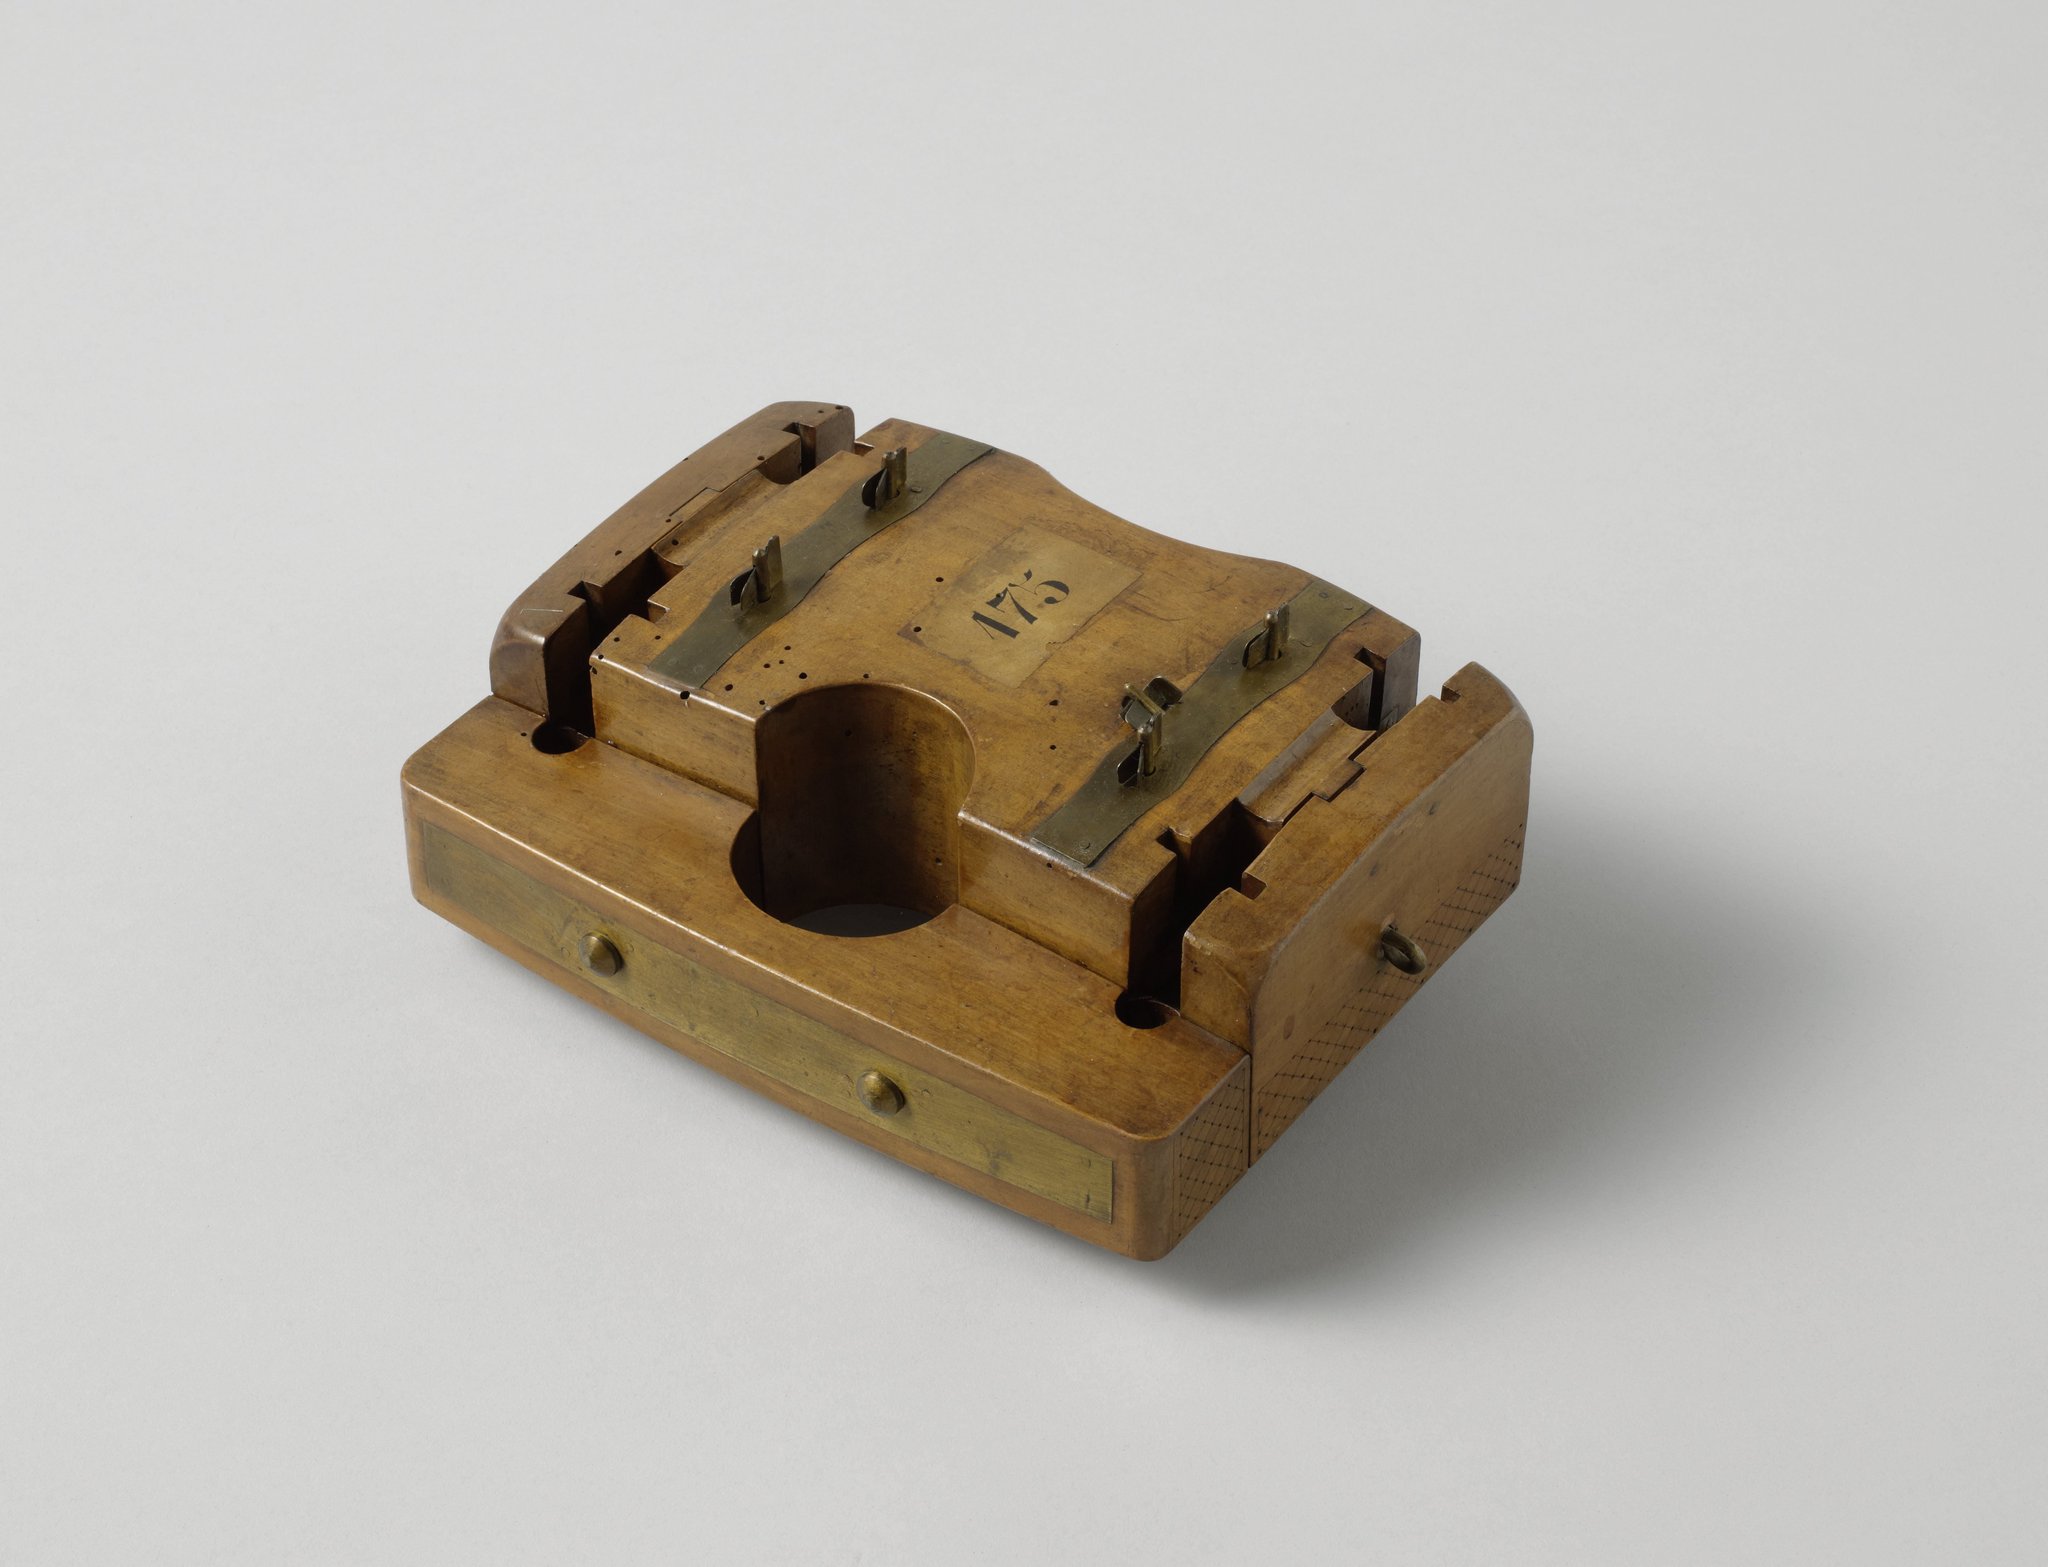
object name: demonstration model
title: Model of a Mast Cap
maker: Anonymous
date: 1780-1840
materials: brass, wood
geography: netherlands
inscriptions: label, on the top: ‘175’ former inventory label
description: Model van een ezelshoofd bestaande uit vier delen: het blok rustend op de mast met vier ogen onderaan, het kalf dat de steng opsluit en twee zijstukken. Tussen de zijstukken en het hoofdblok zijn uitsparingen voor in totaal vier schijven voor de stengewindrepen, die de stengewindreepblokken vervangen.